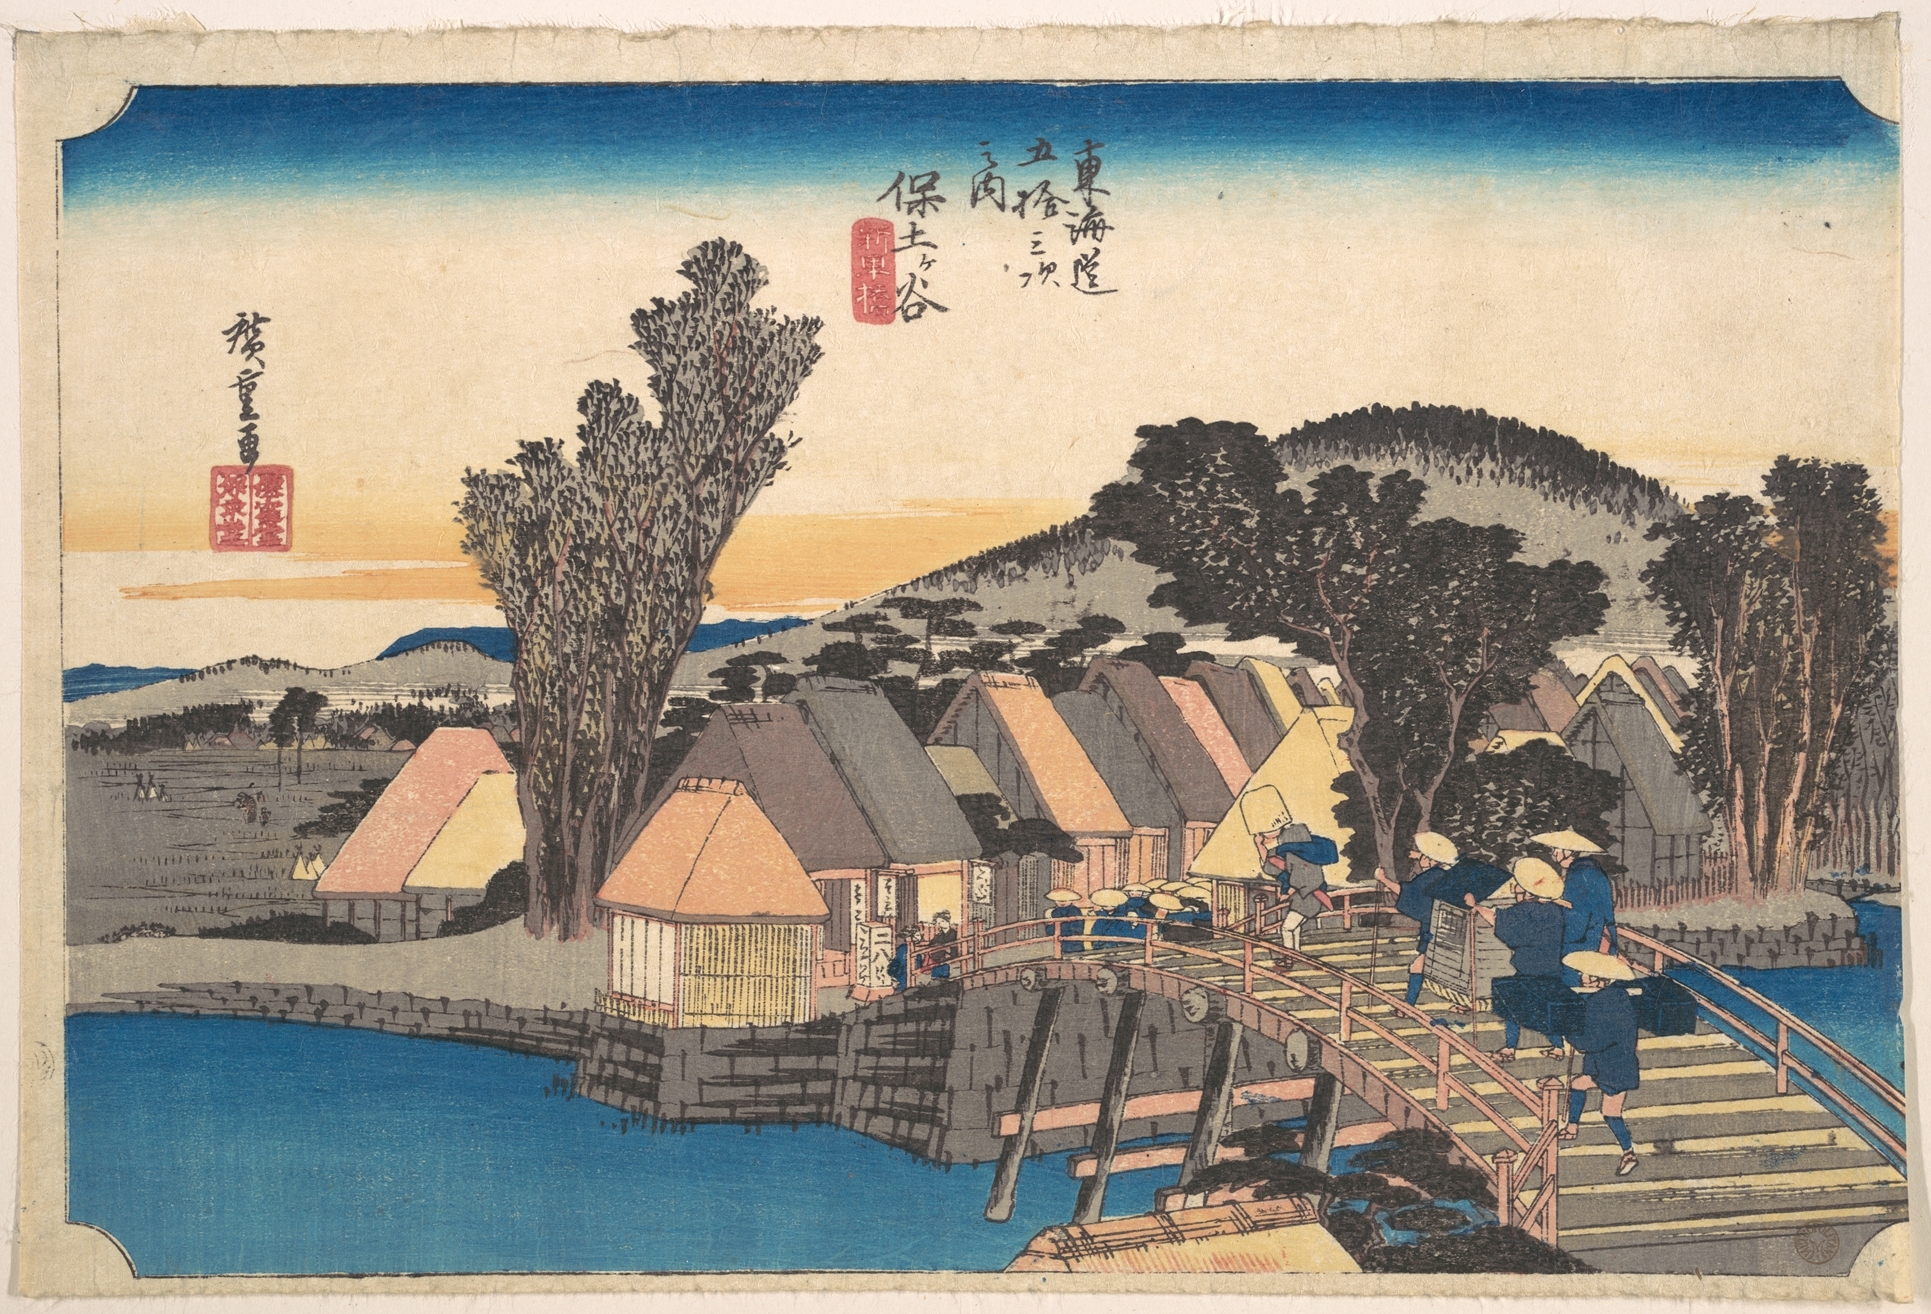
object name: print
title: Hodogaya Station and Shinkame Bridge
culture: japanese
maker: utagawa hiroshige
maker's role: artist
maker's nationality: japanese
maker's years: 1797-1858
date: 1834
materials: ink, paper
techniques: woodblock print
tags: human figures,bridges,landscapes